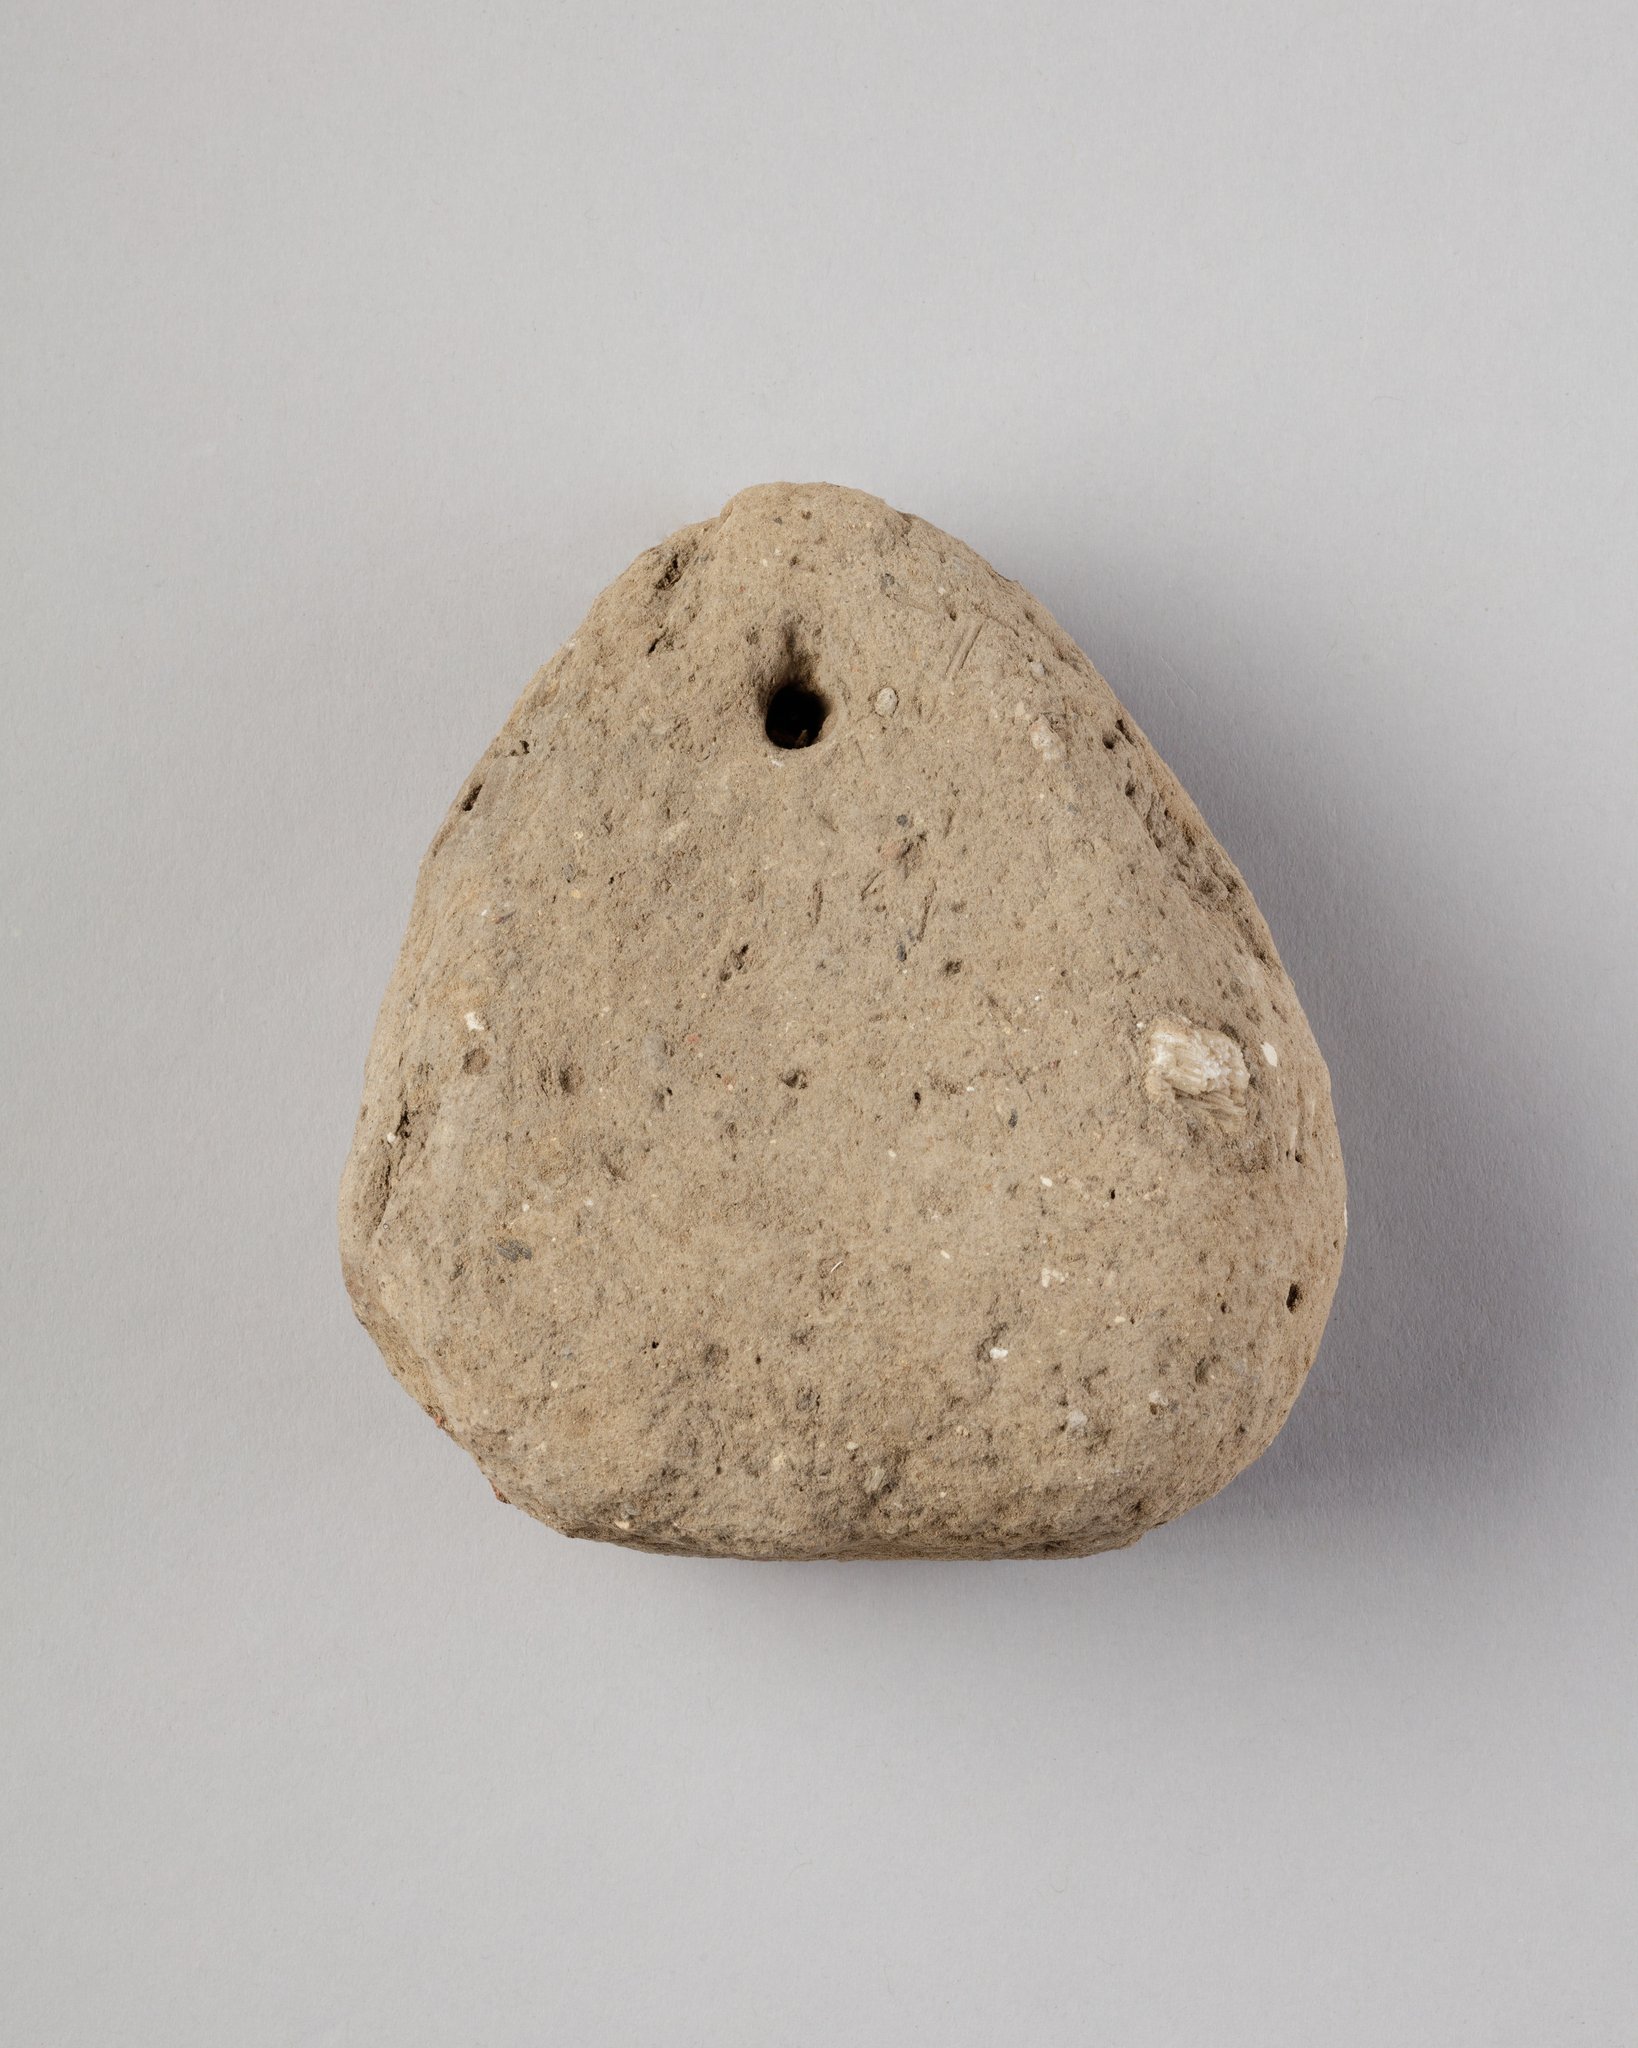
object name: loom weight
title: Loom Weight (?)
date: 1295-1070 BCE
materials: mud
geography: egypt